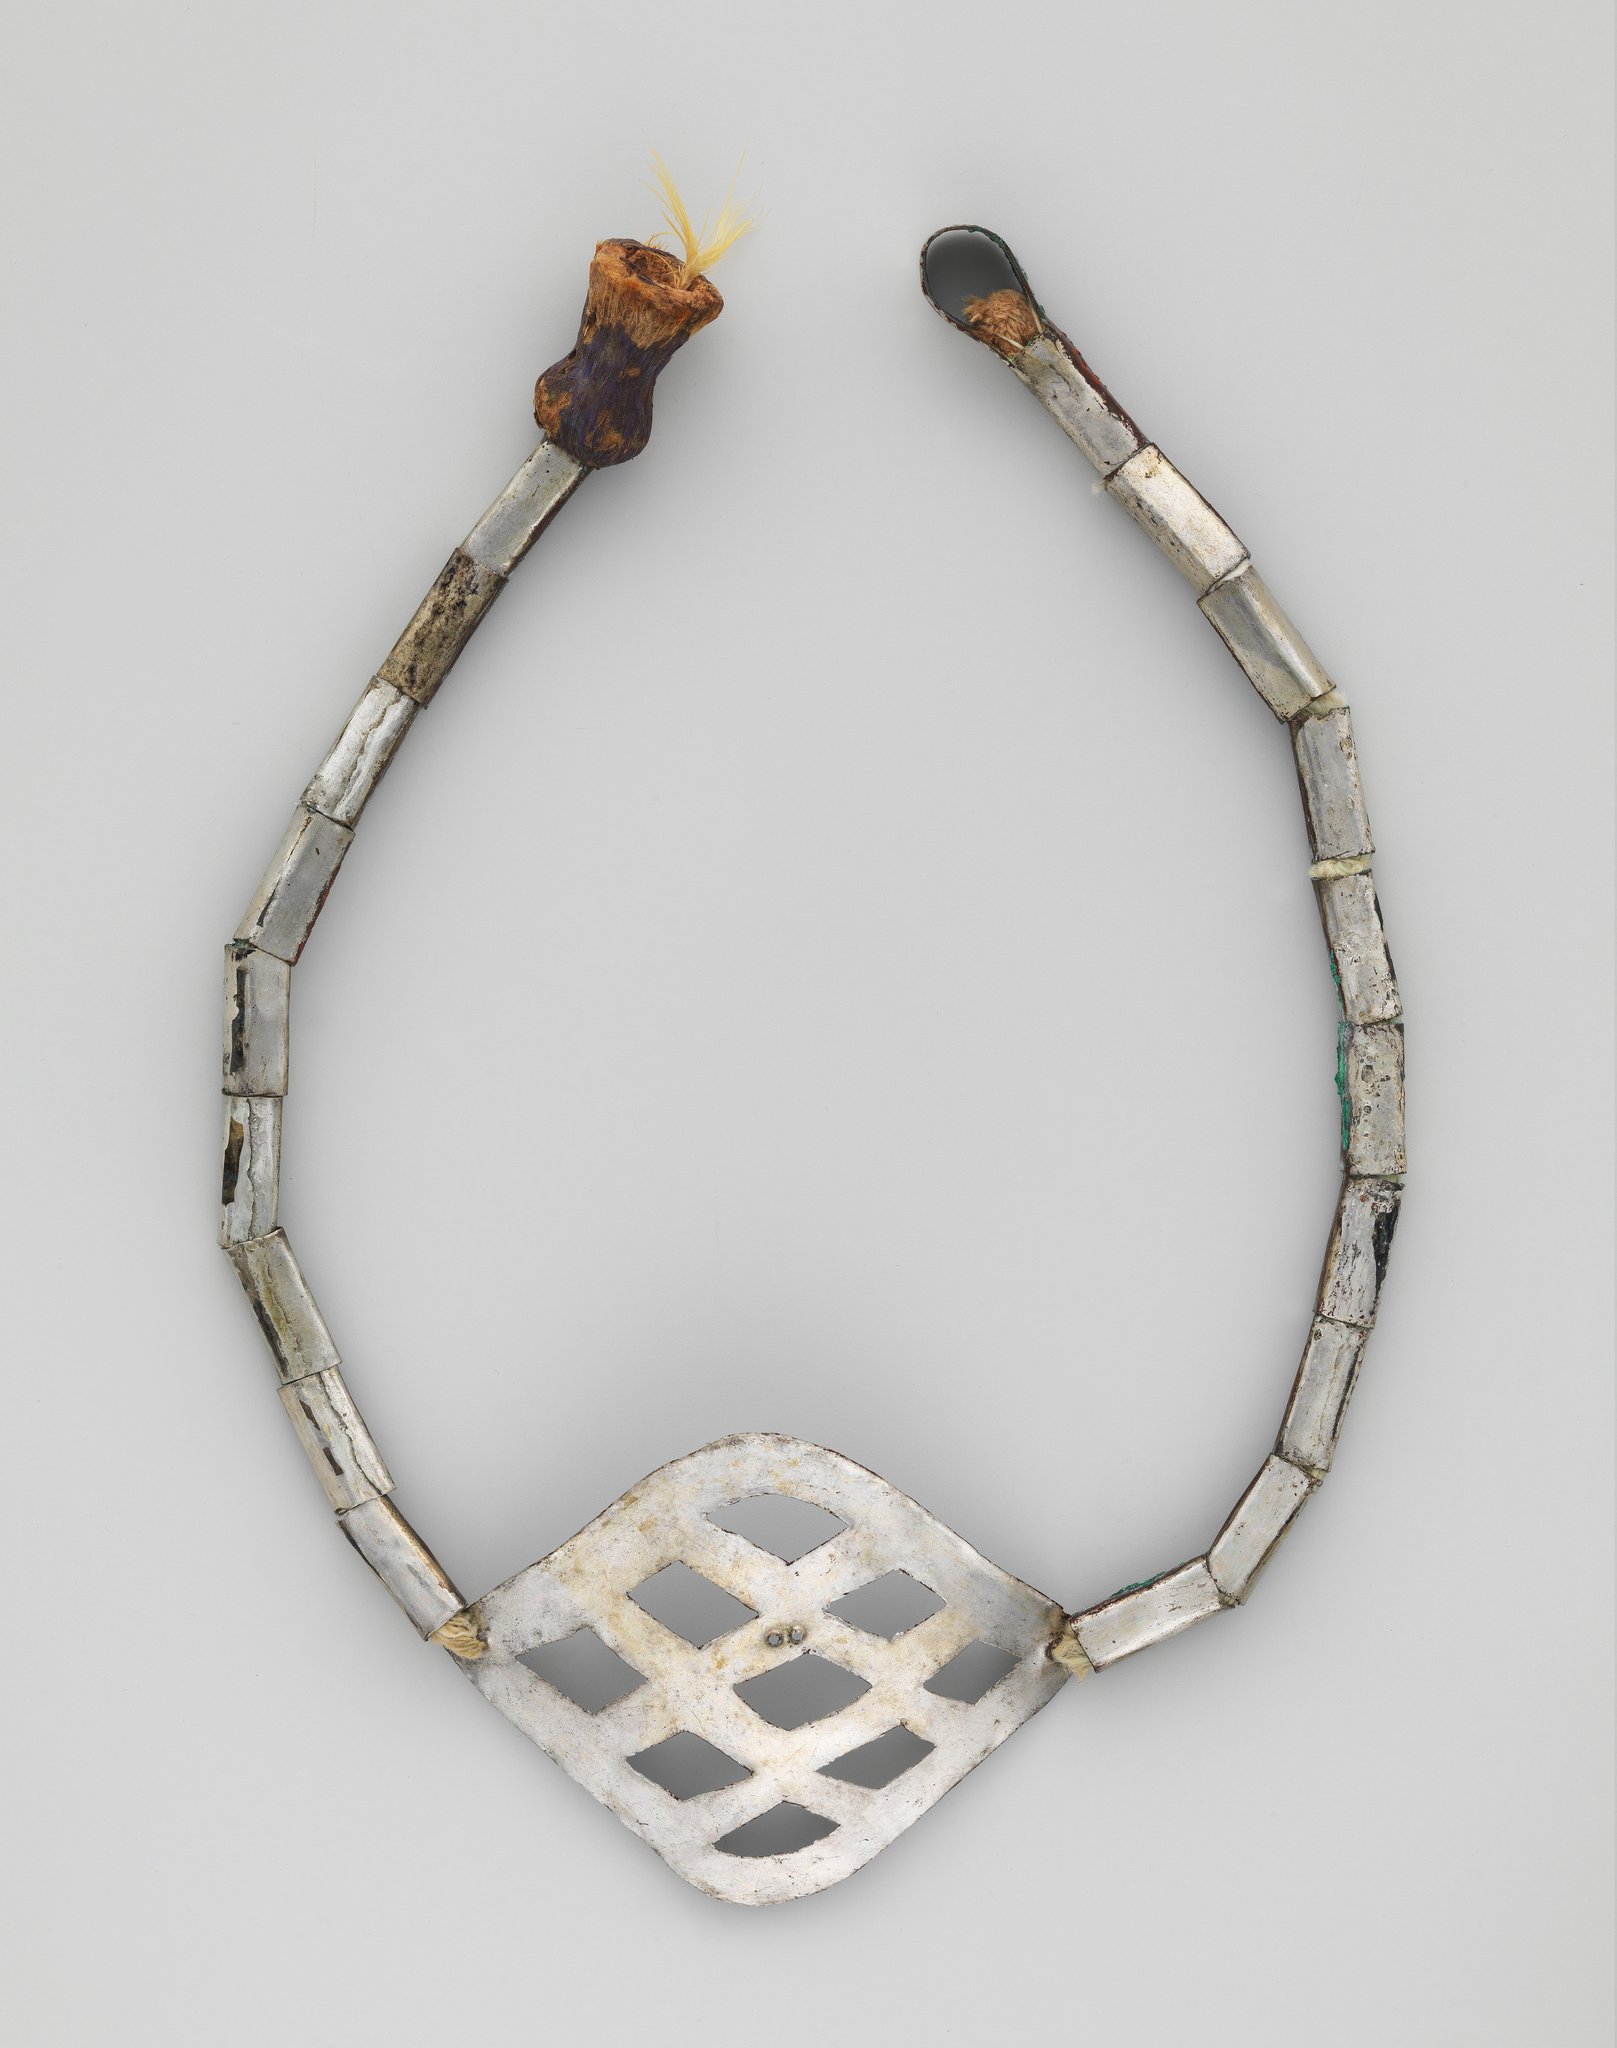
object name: sling shot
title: Miniature slingshot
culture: chancay or chimú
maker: chimú or chancay artist(s)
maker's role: artist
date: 1300-1470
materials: feather, silver, wood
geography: peru